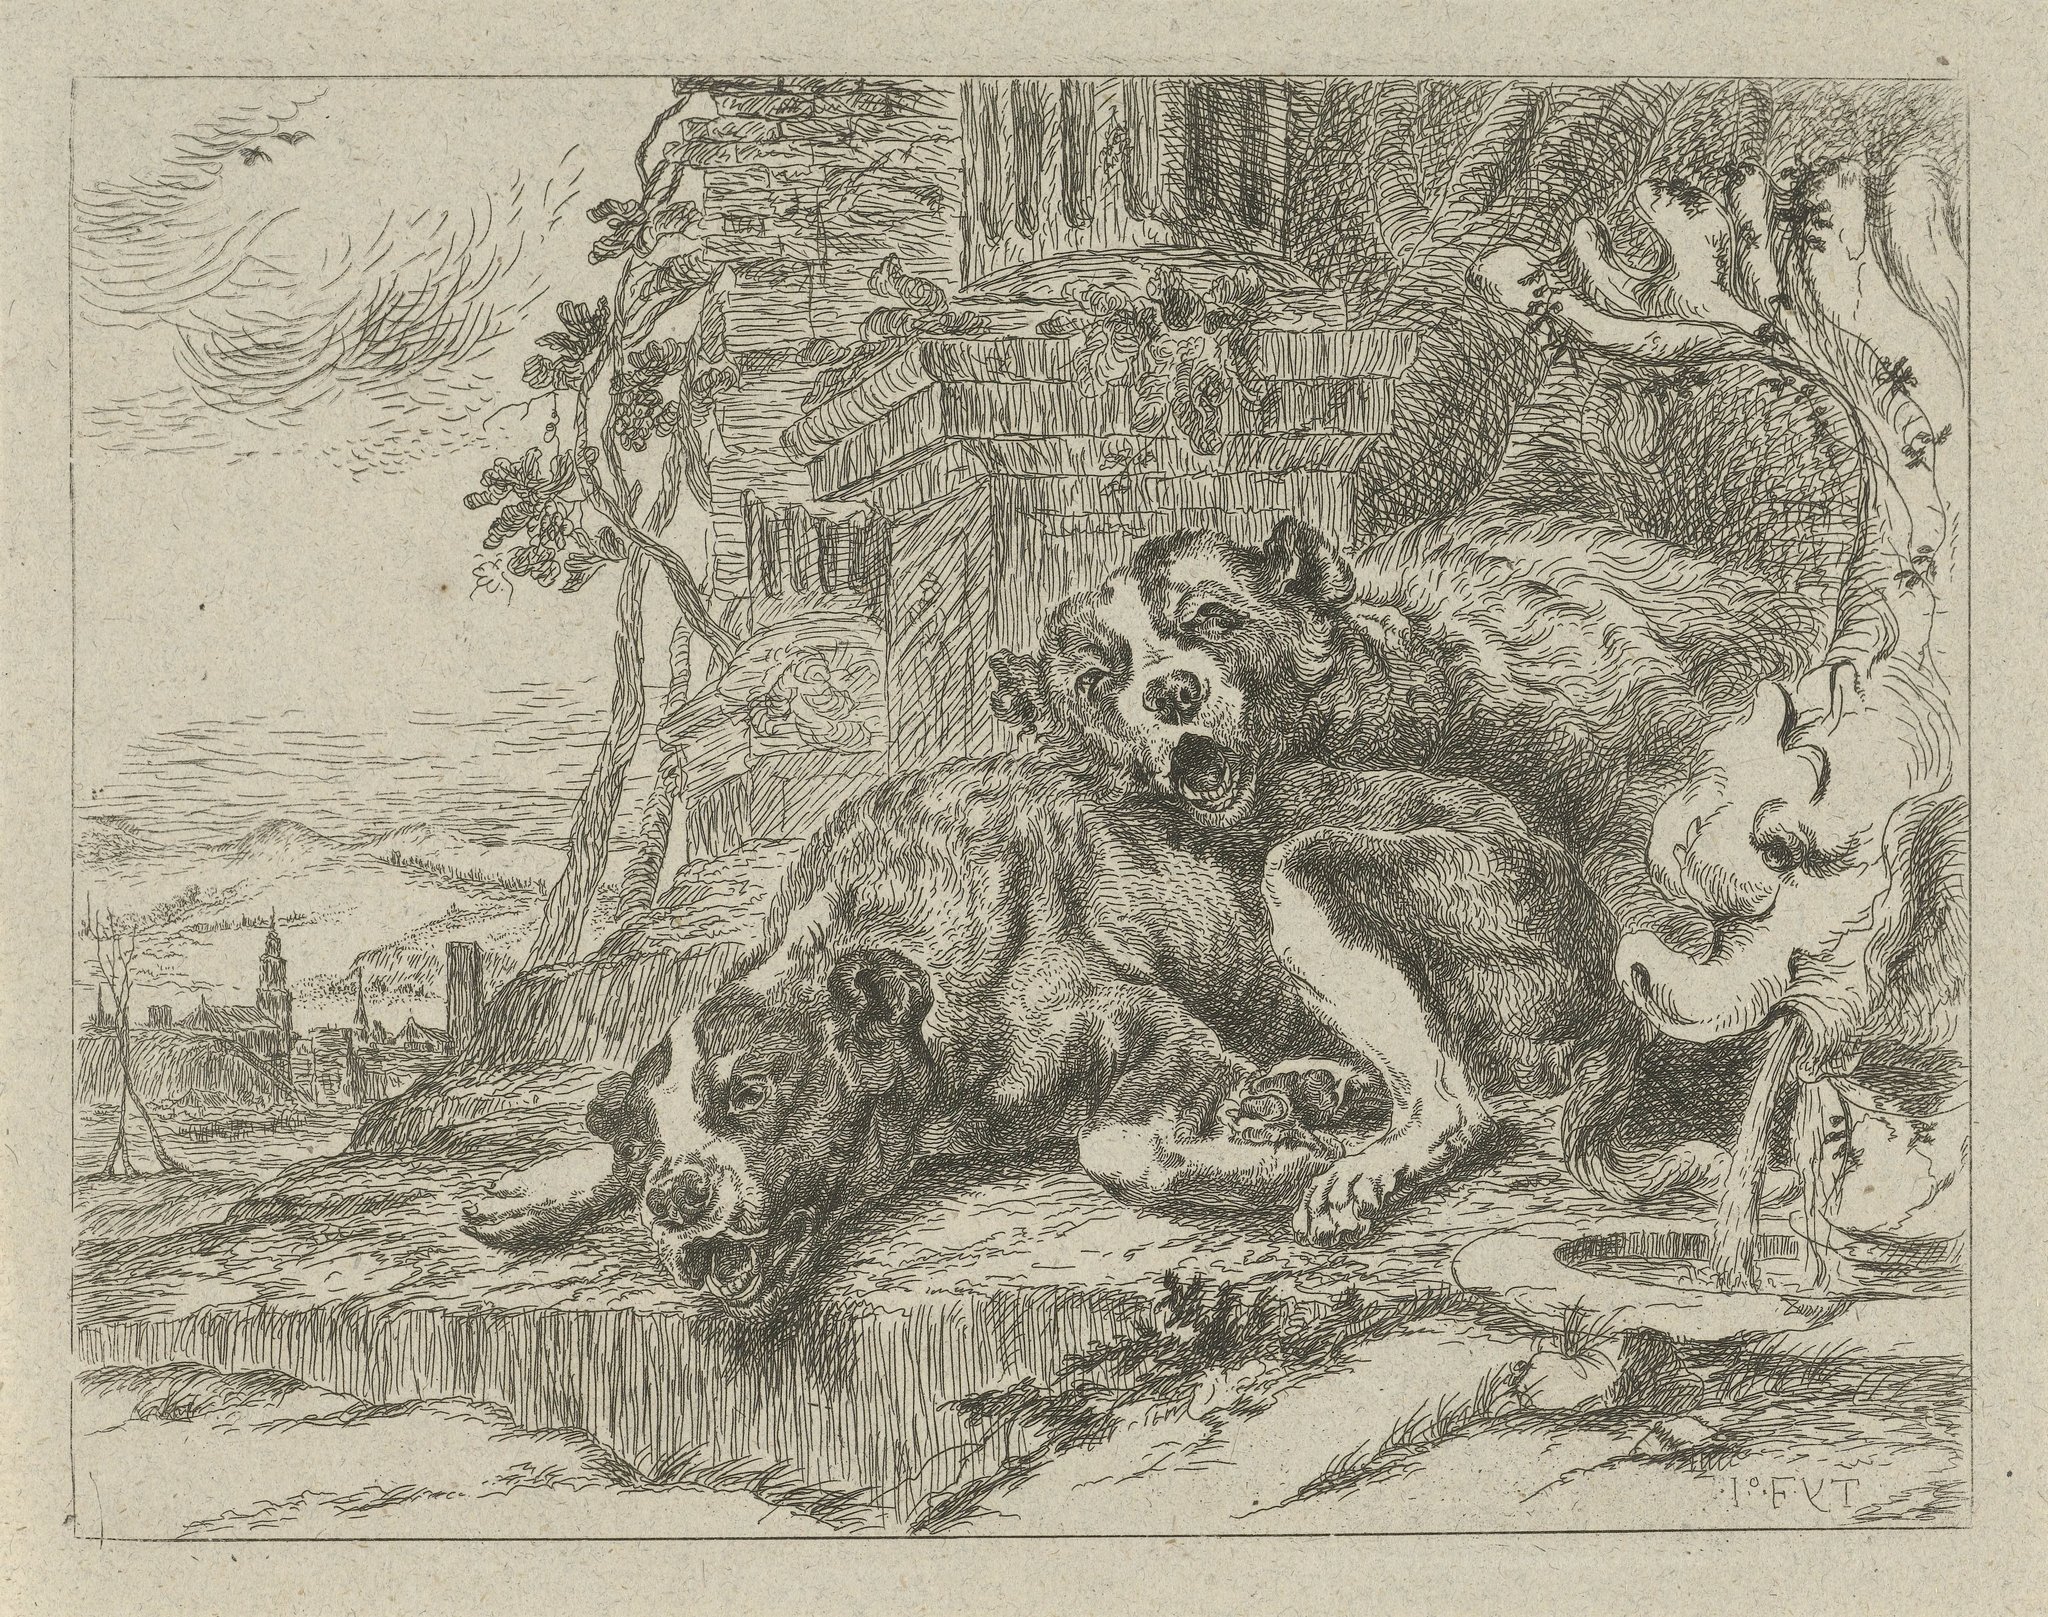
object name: print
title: Twee liggende honden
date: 1642-1711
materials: paper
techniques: etching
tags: dog